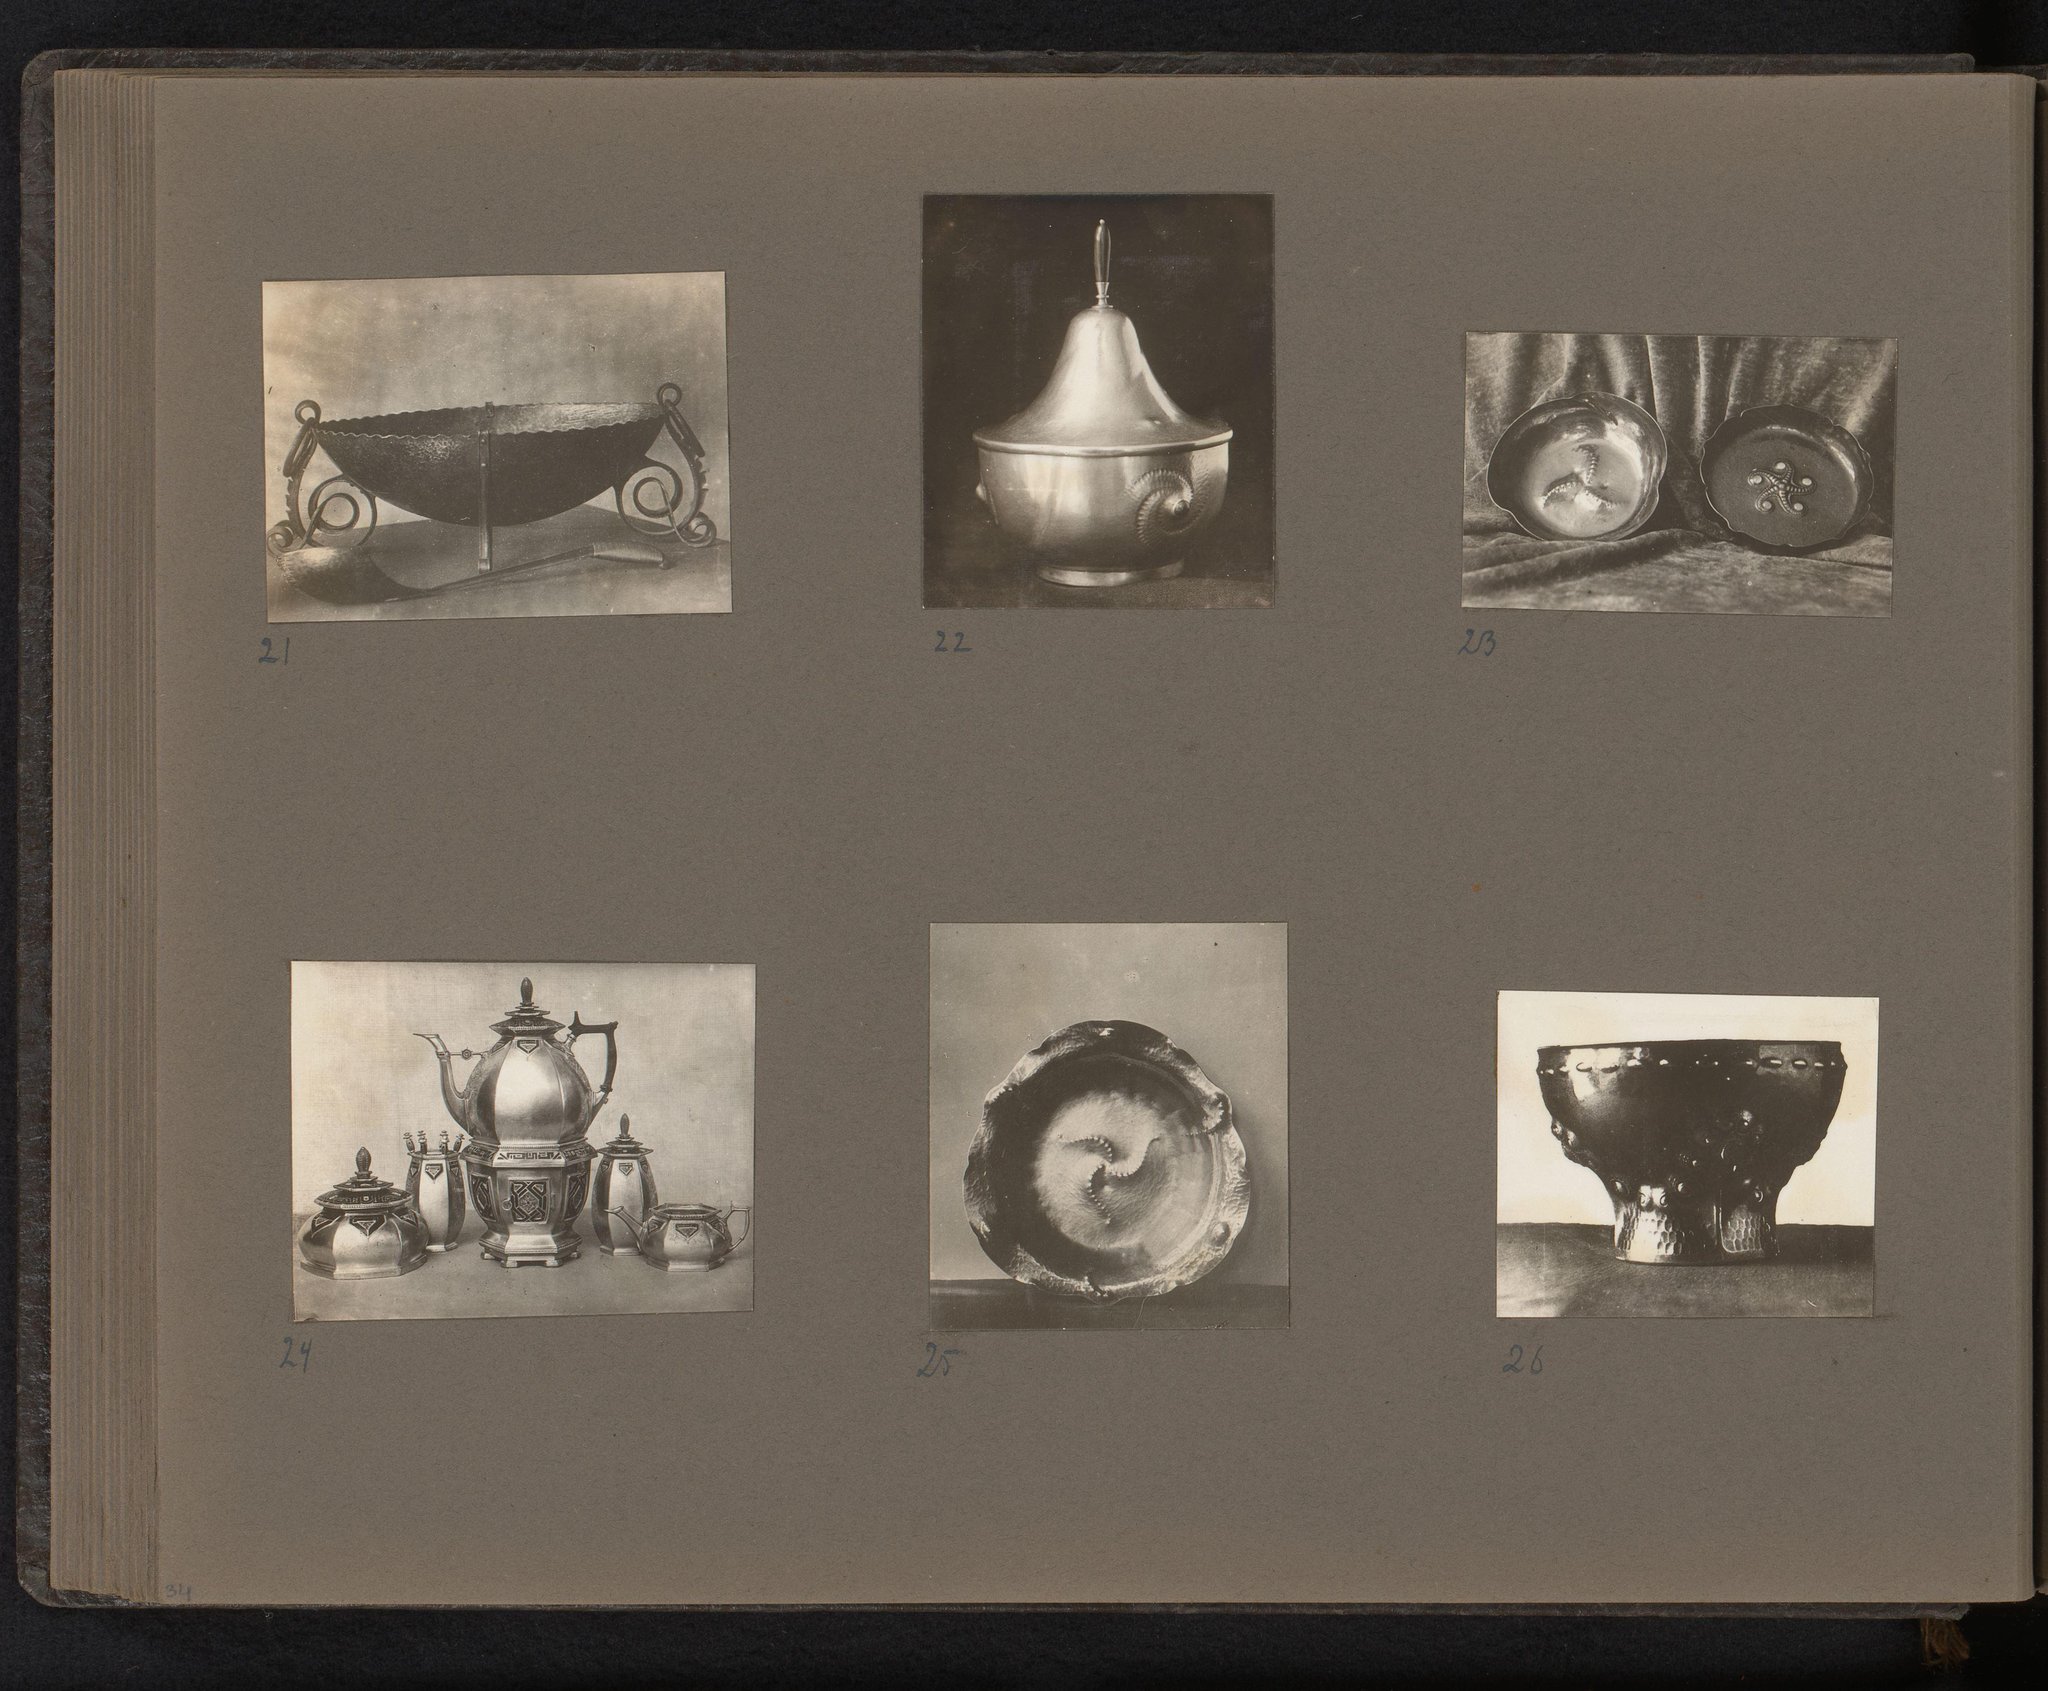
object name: photograph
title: Vijf schalen en een set voor thee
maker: Anonymous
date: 1920-1940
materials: paper, photographic support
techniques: gelatin silver print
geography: netherlands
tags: sugar-basin, tea-pot; samovar, dish, plate, saucer, container of metal: bucket, can, canister, drum, tin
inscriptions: number: ‘21 - 22 - 23/ 24 - 25 -26’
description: Vijf foto's van diverse schalen, waarvan één met deksel. Daarnaast een foto van een set benodigdheden voor thee: een theepot, een suikerpot, een houder voor lepels en een rechaud. Deze foto's maken deel uit van een album.